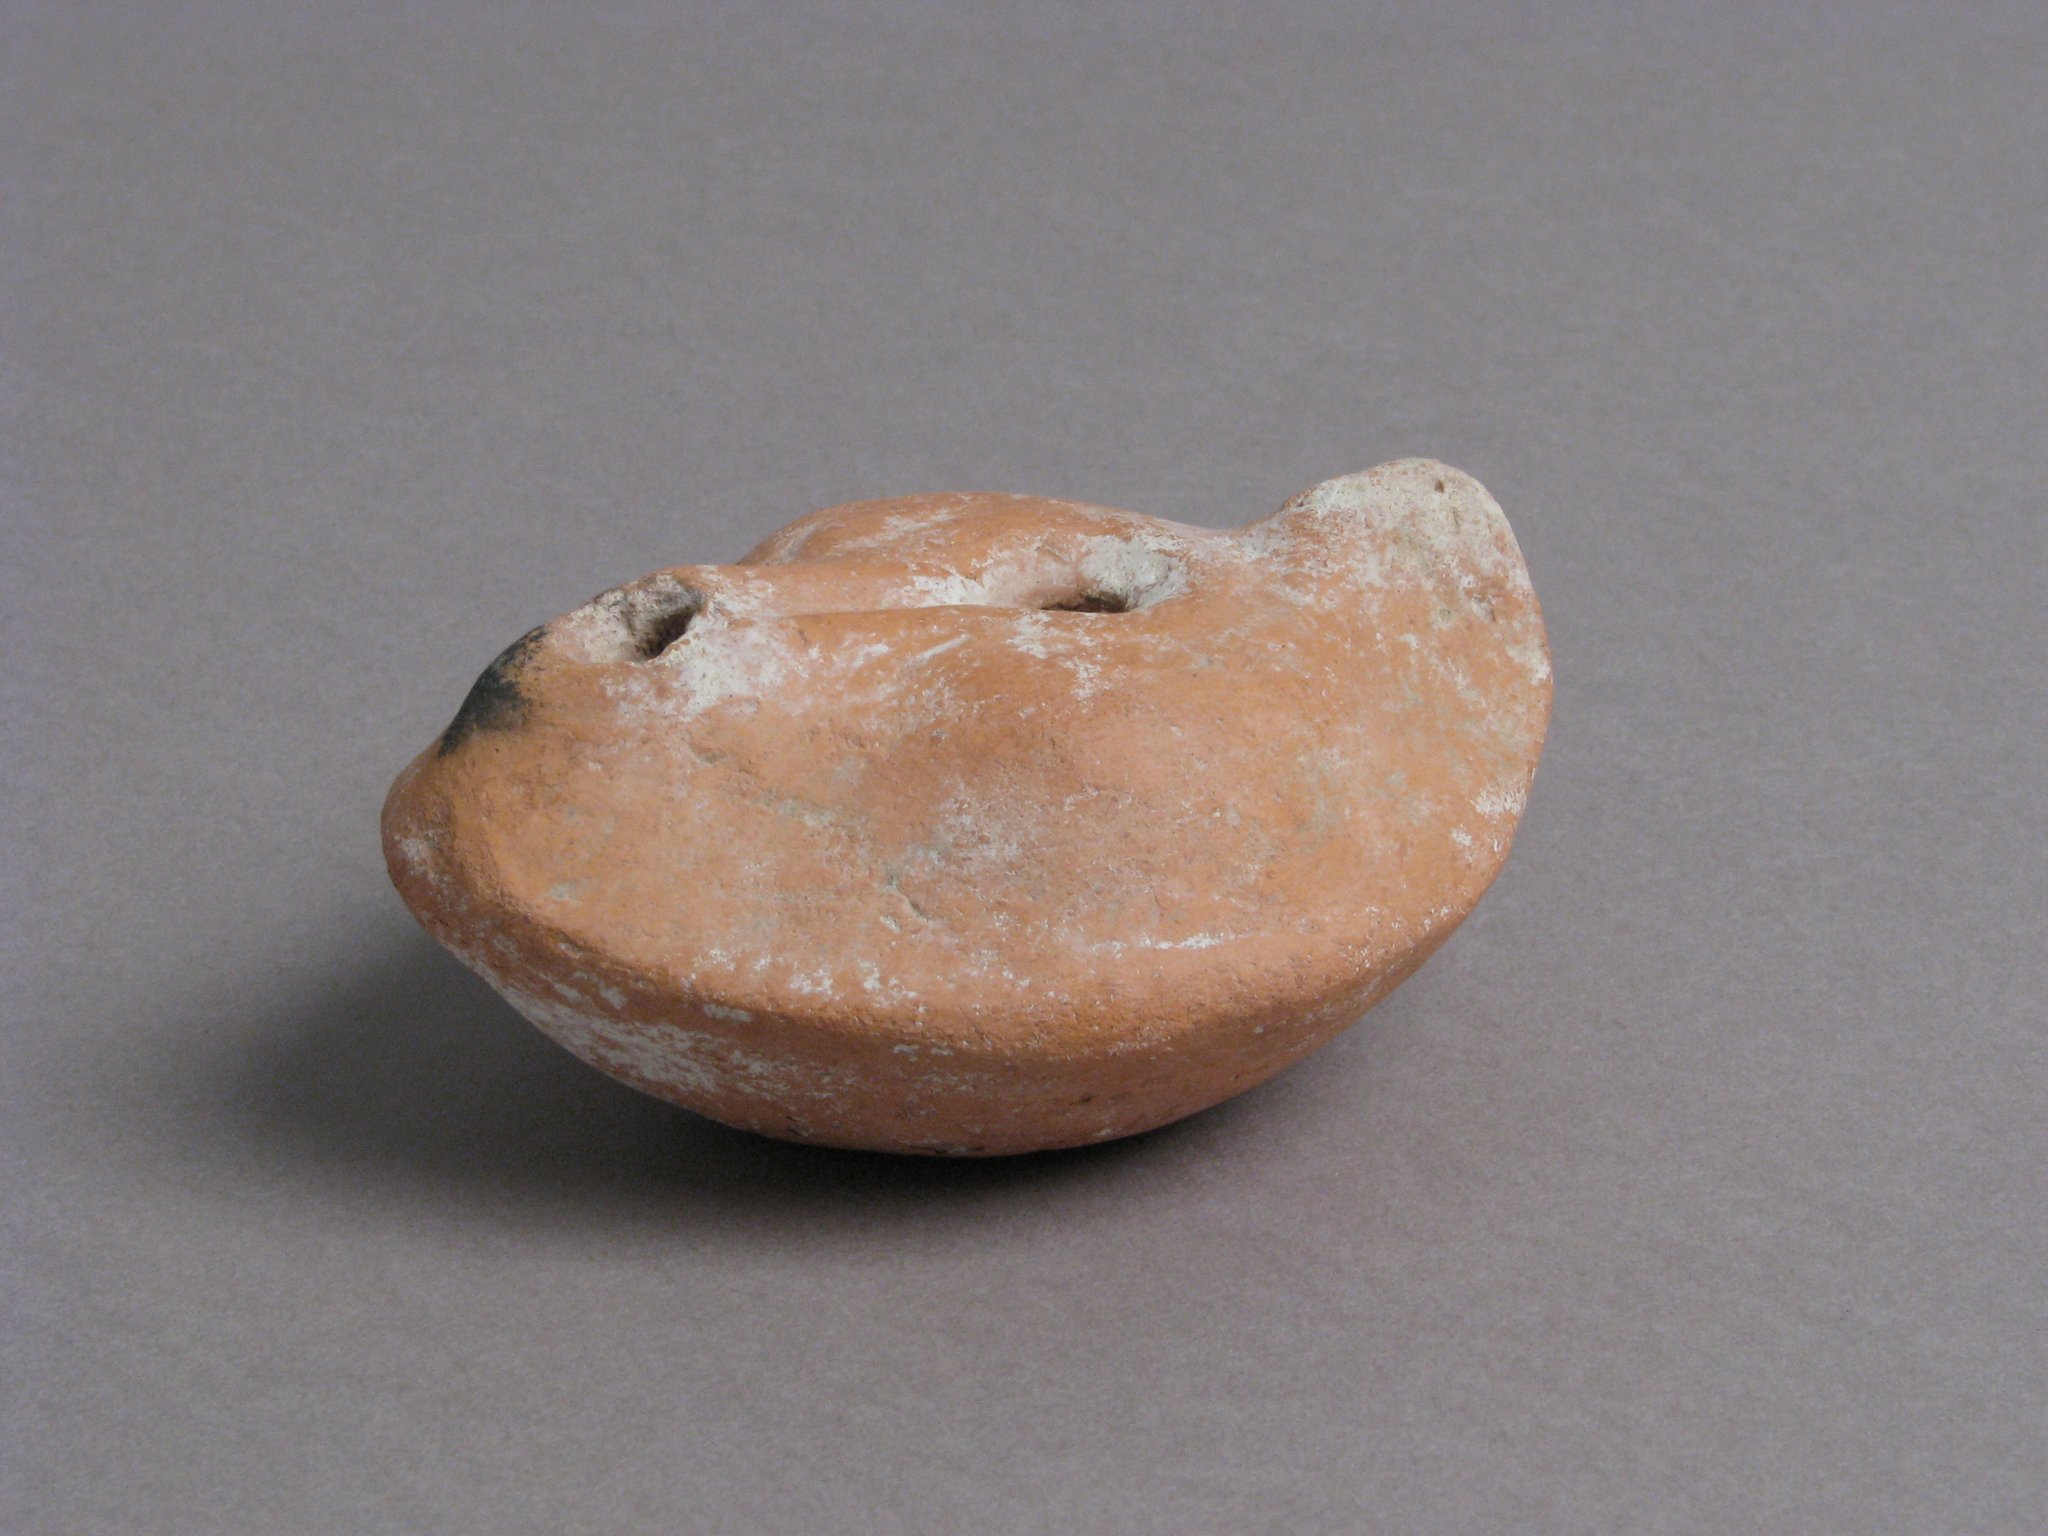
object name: lamp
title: Oil Lamp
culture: coptic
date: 301-700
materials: earthenware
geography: egypt